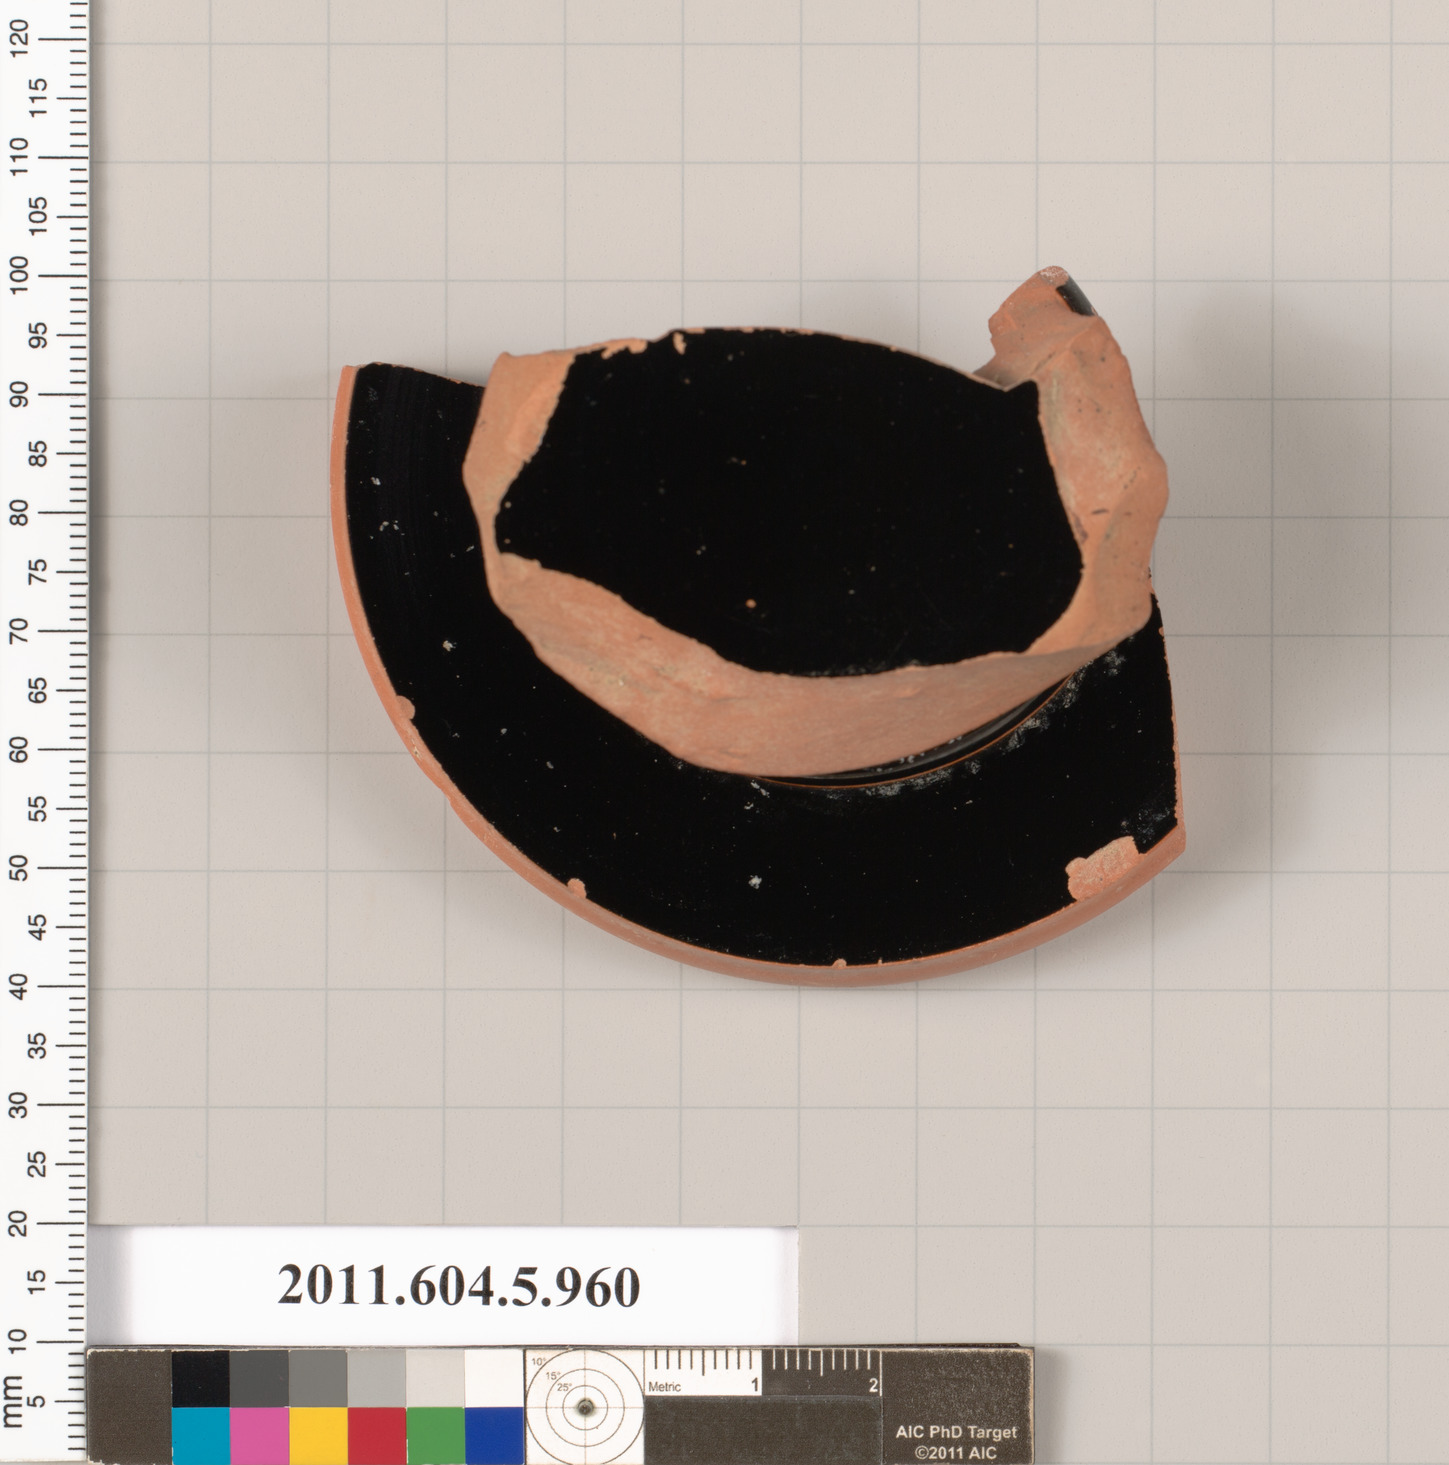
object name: kylix fragment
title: Terracotta fragment of a kylix (drinking cup)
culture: greek, attic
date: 600-401 BCE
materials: terracotta